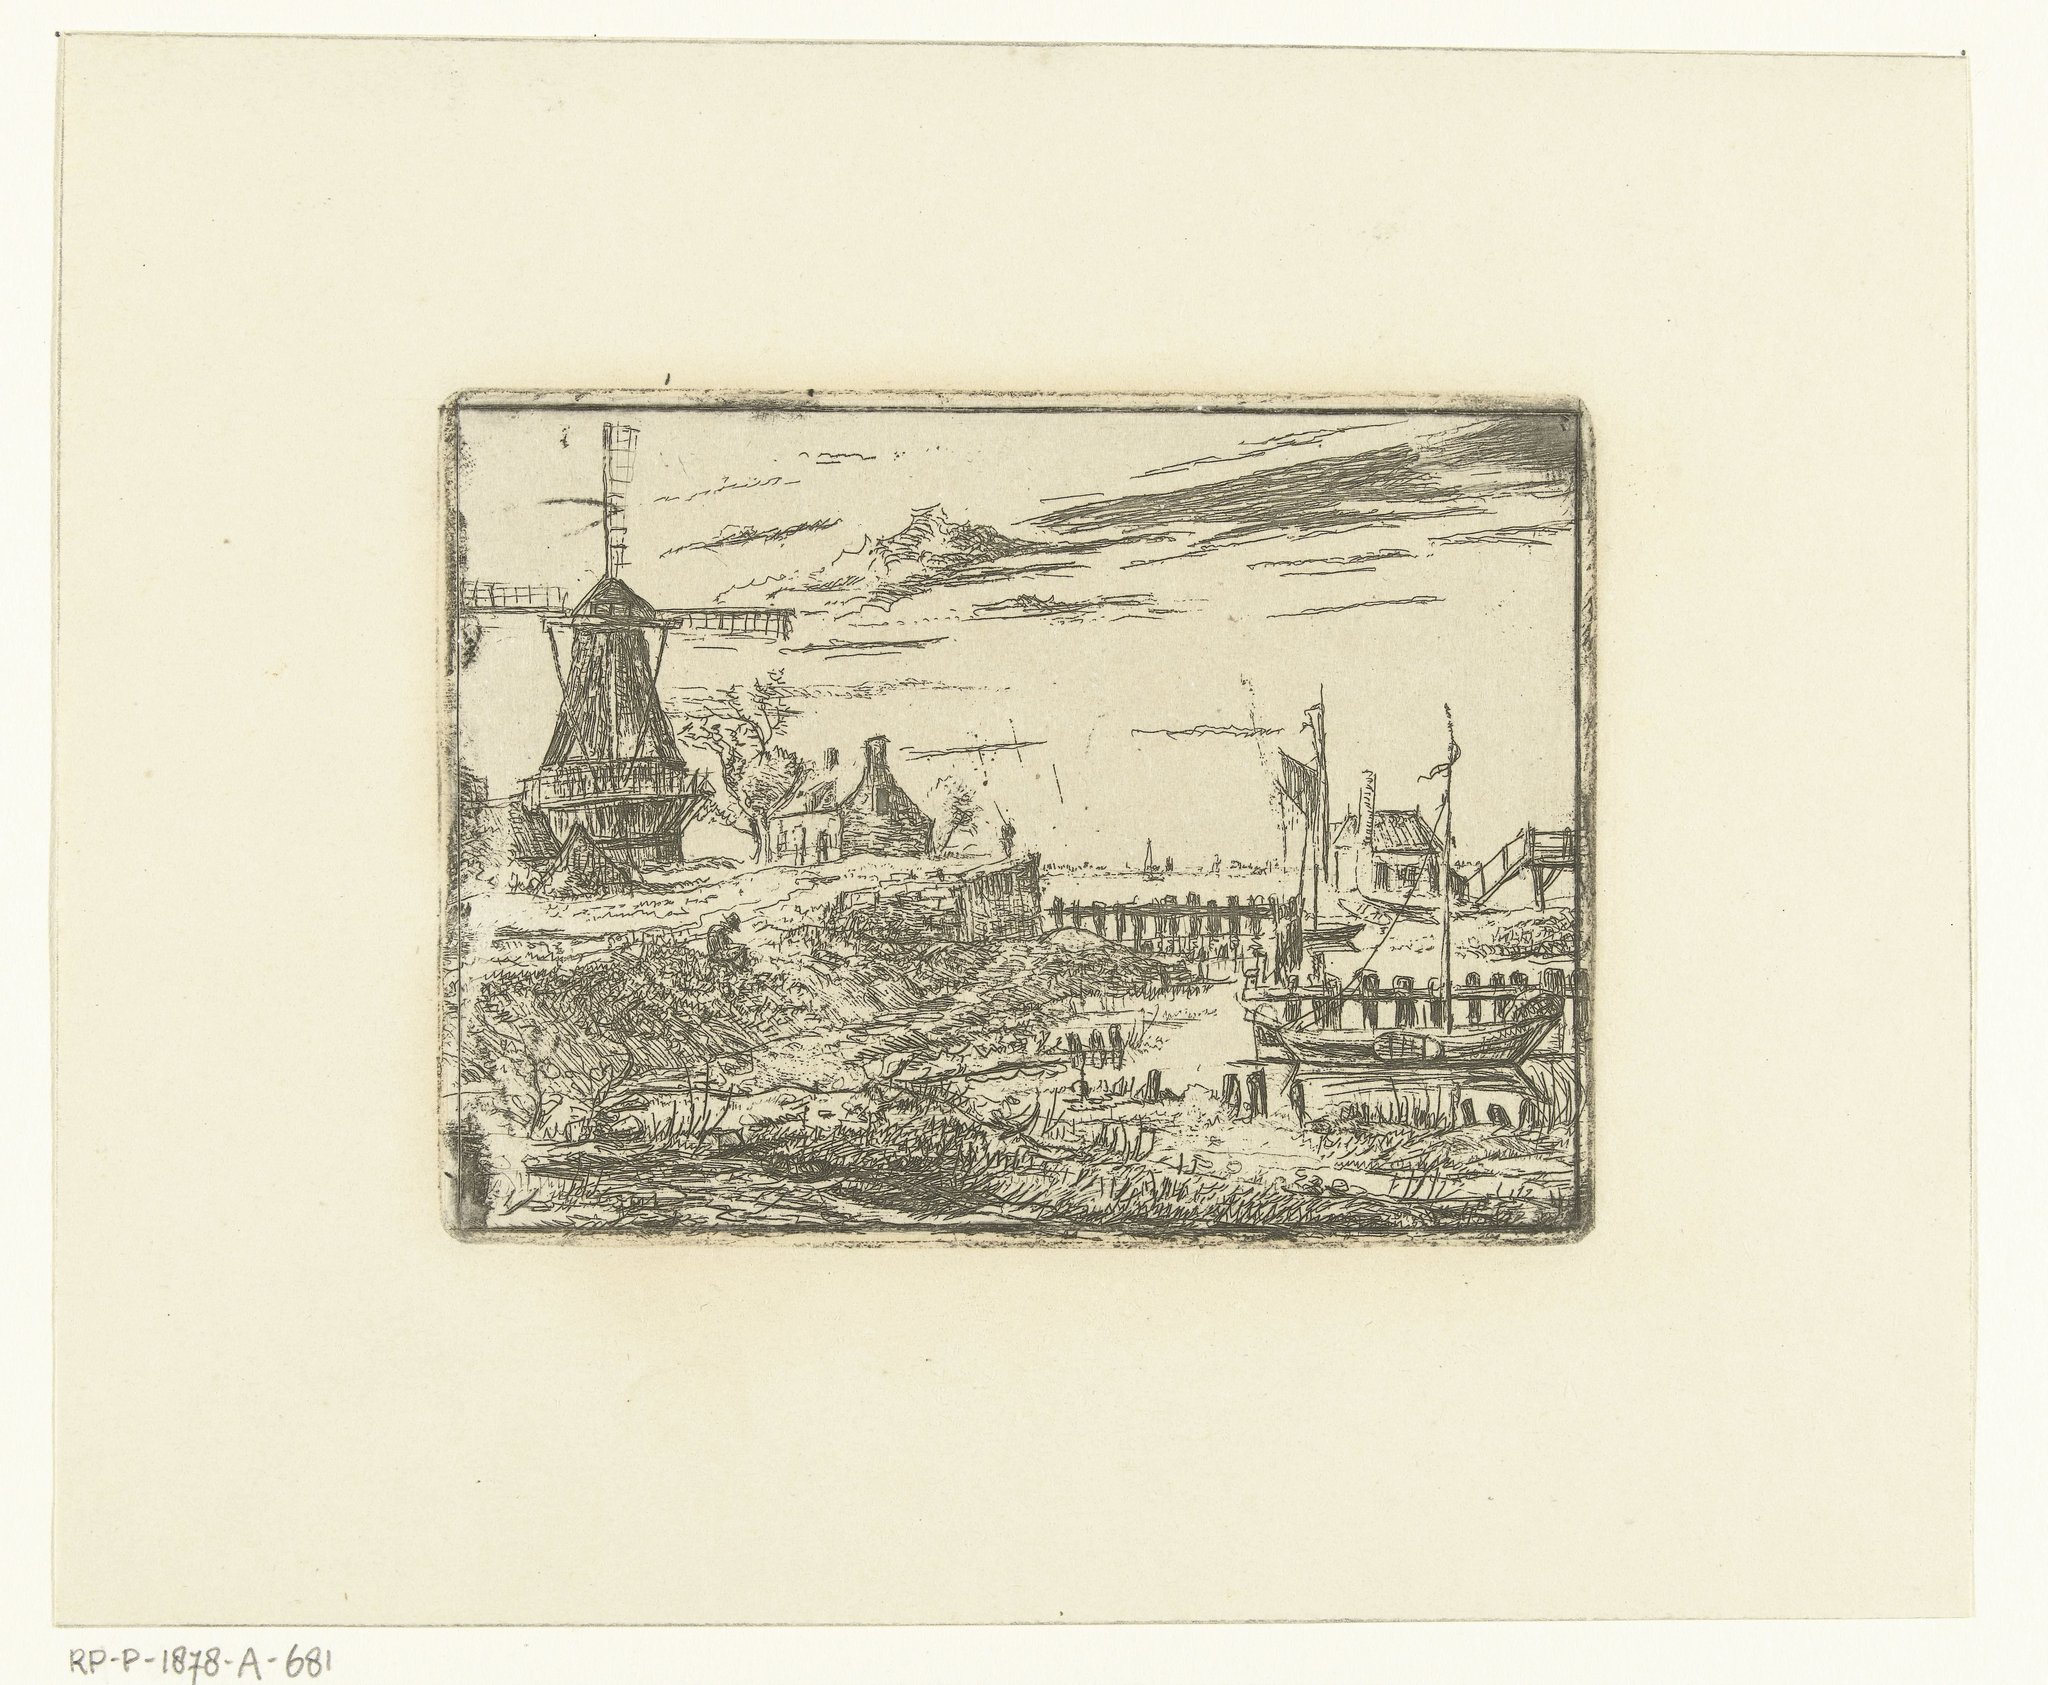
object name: print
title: Landschap met molen en schip in haven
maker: albertus brondgeest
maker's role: draughtsman, print maker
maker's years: 1786-1849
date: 1796-1849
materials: paper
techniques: etching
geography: netherlands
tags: water course, windmill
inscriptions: collector's mark: Lugt 2228